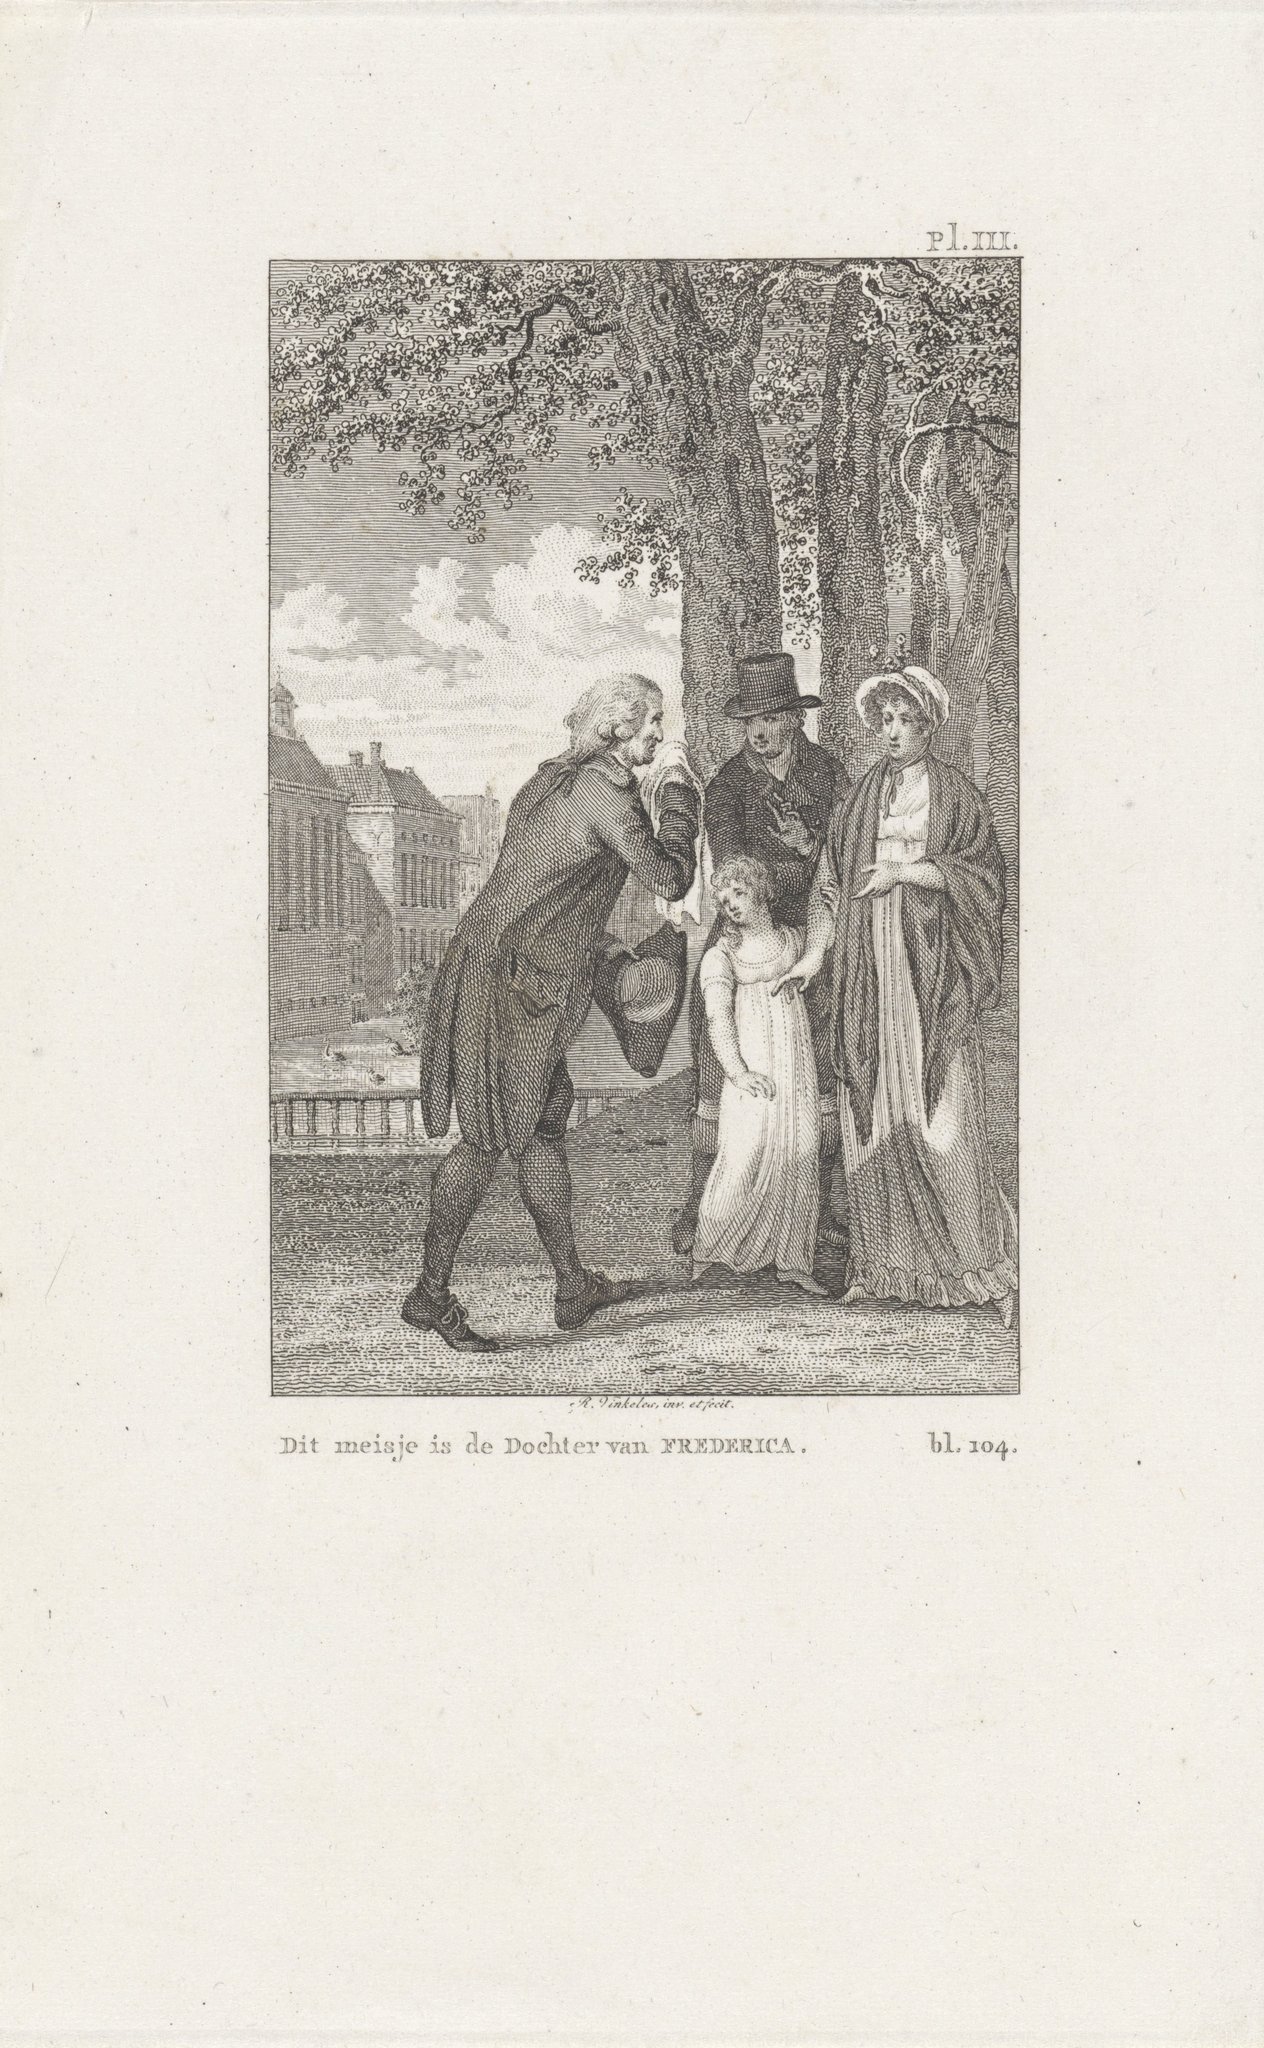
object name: print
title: Meneer van Stalen ontmoet zijn kleindochter Fritsje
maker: reinier vinkeles (i)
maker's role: draughtsman, print maker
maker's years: 1741-1816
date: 1804-1805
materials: paper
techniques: engraving, etching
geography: amsterdam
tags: trees, family, descendance, conversation, dialogue; conversation piece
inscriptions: collector's mark: Lugt 2228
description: Deze prent is ook gebruikt als illustratie in: Loosjes, Adriaan Pietersz. Zedelijke Verhaalen. Haarlem: Adriaan Loosjes, 1804-1805. Tweede druk Haarlem: Adriaan Loosjes, 1815.